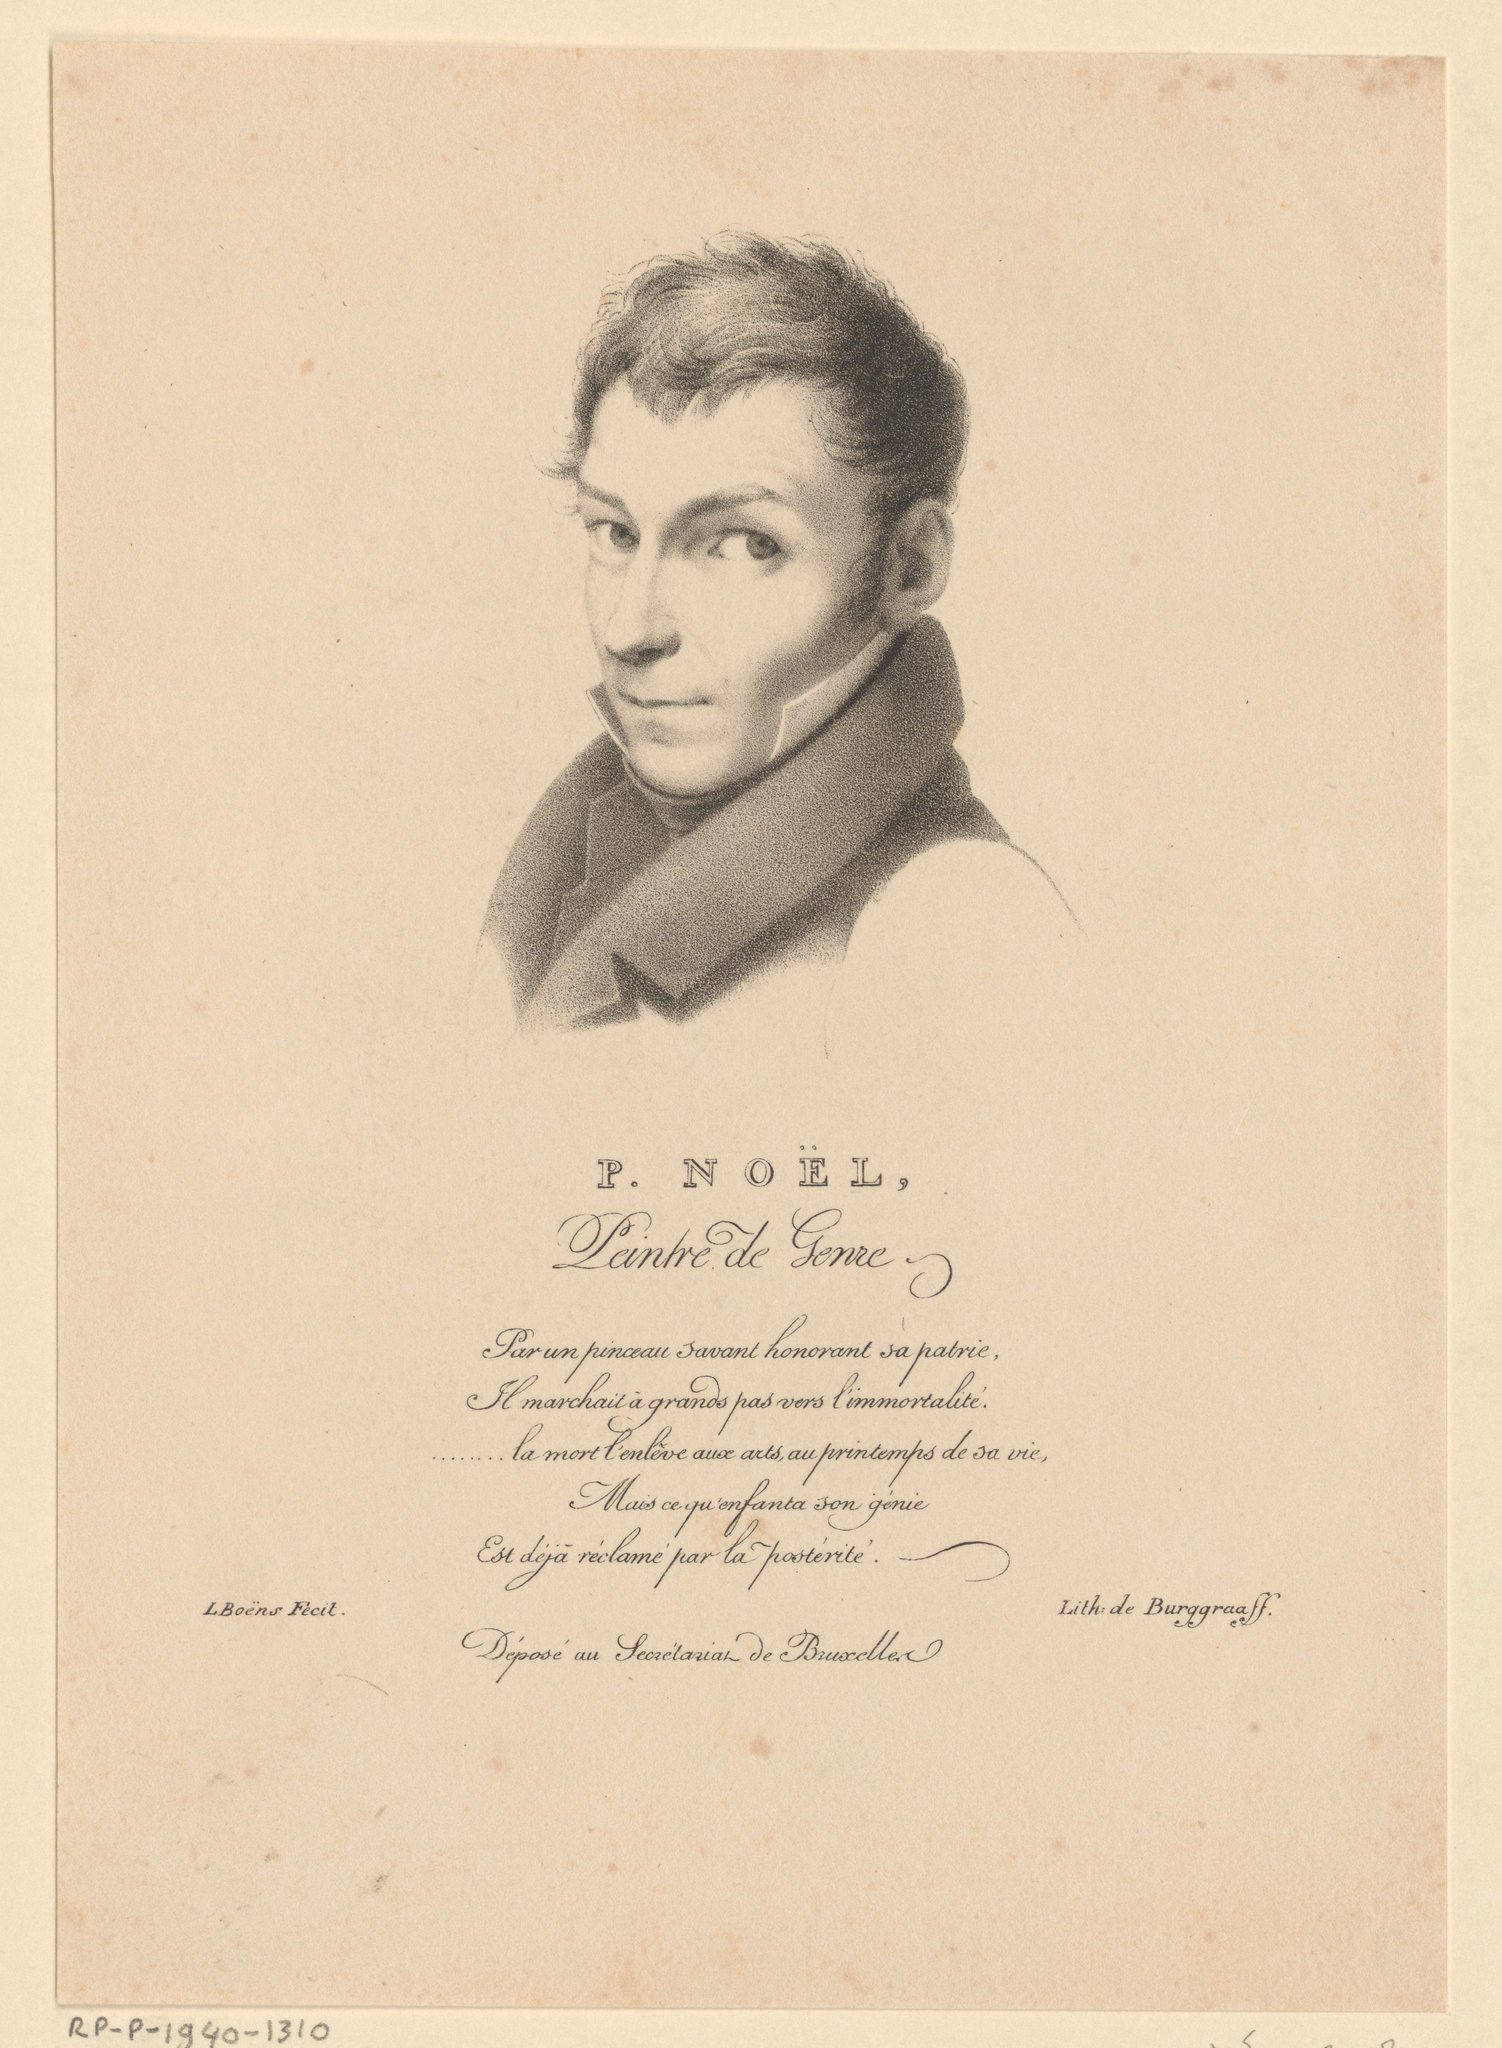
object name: print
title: Portret van Peter Paul Joseph Noël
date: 1805-1837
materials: paper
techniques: lithograph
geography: brussels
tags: painter, print maker, draughtsman, peter paul joseph noël, historical persons, portrait, self-portrait of painter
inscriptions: collector's mark: Lugt 2228, collector's mark: Lugt 2760